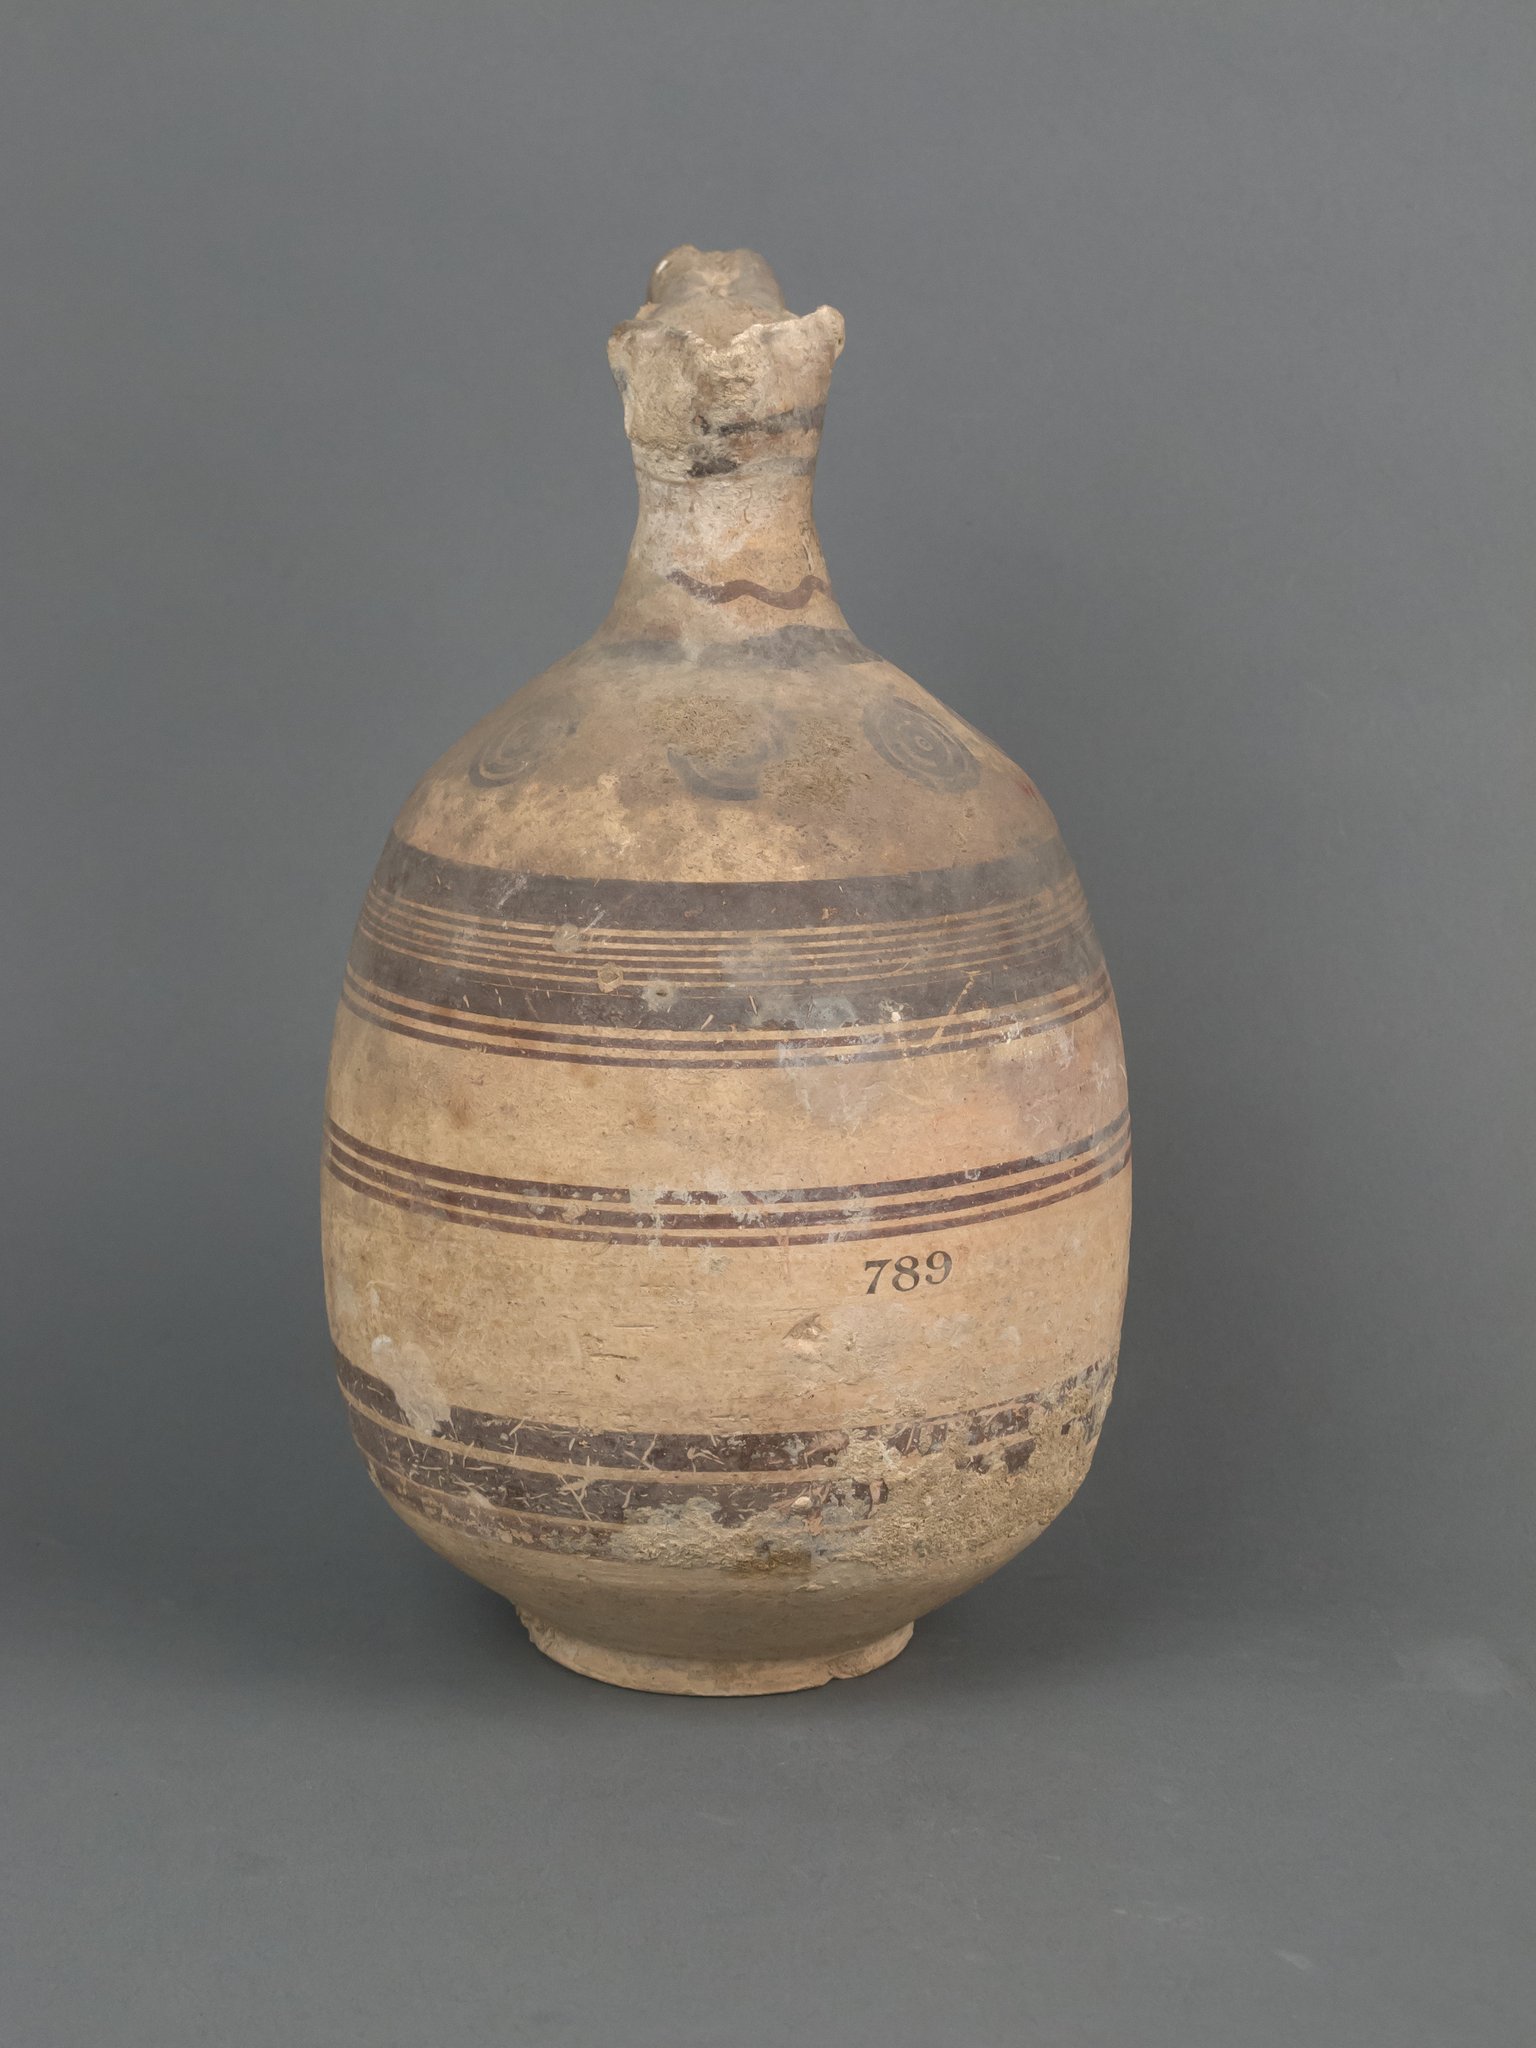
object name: jug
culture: cypriot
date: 600-480 BCE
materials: terracotta